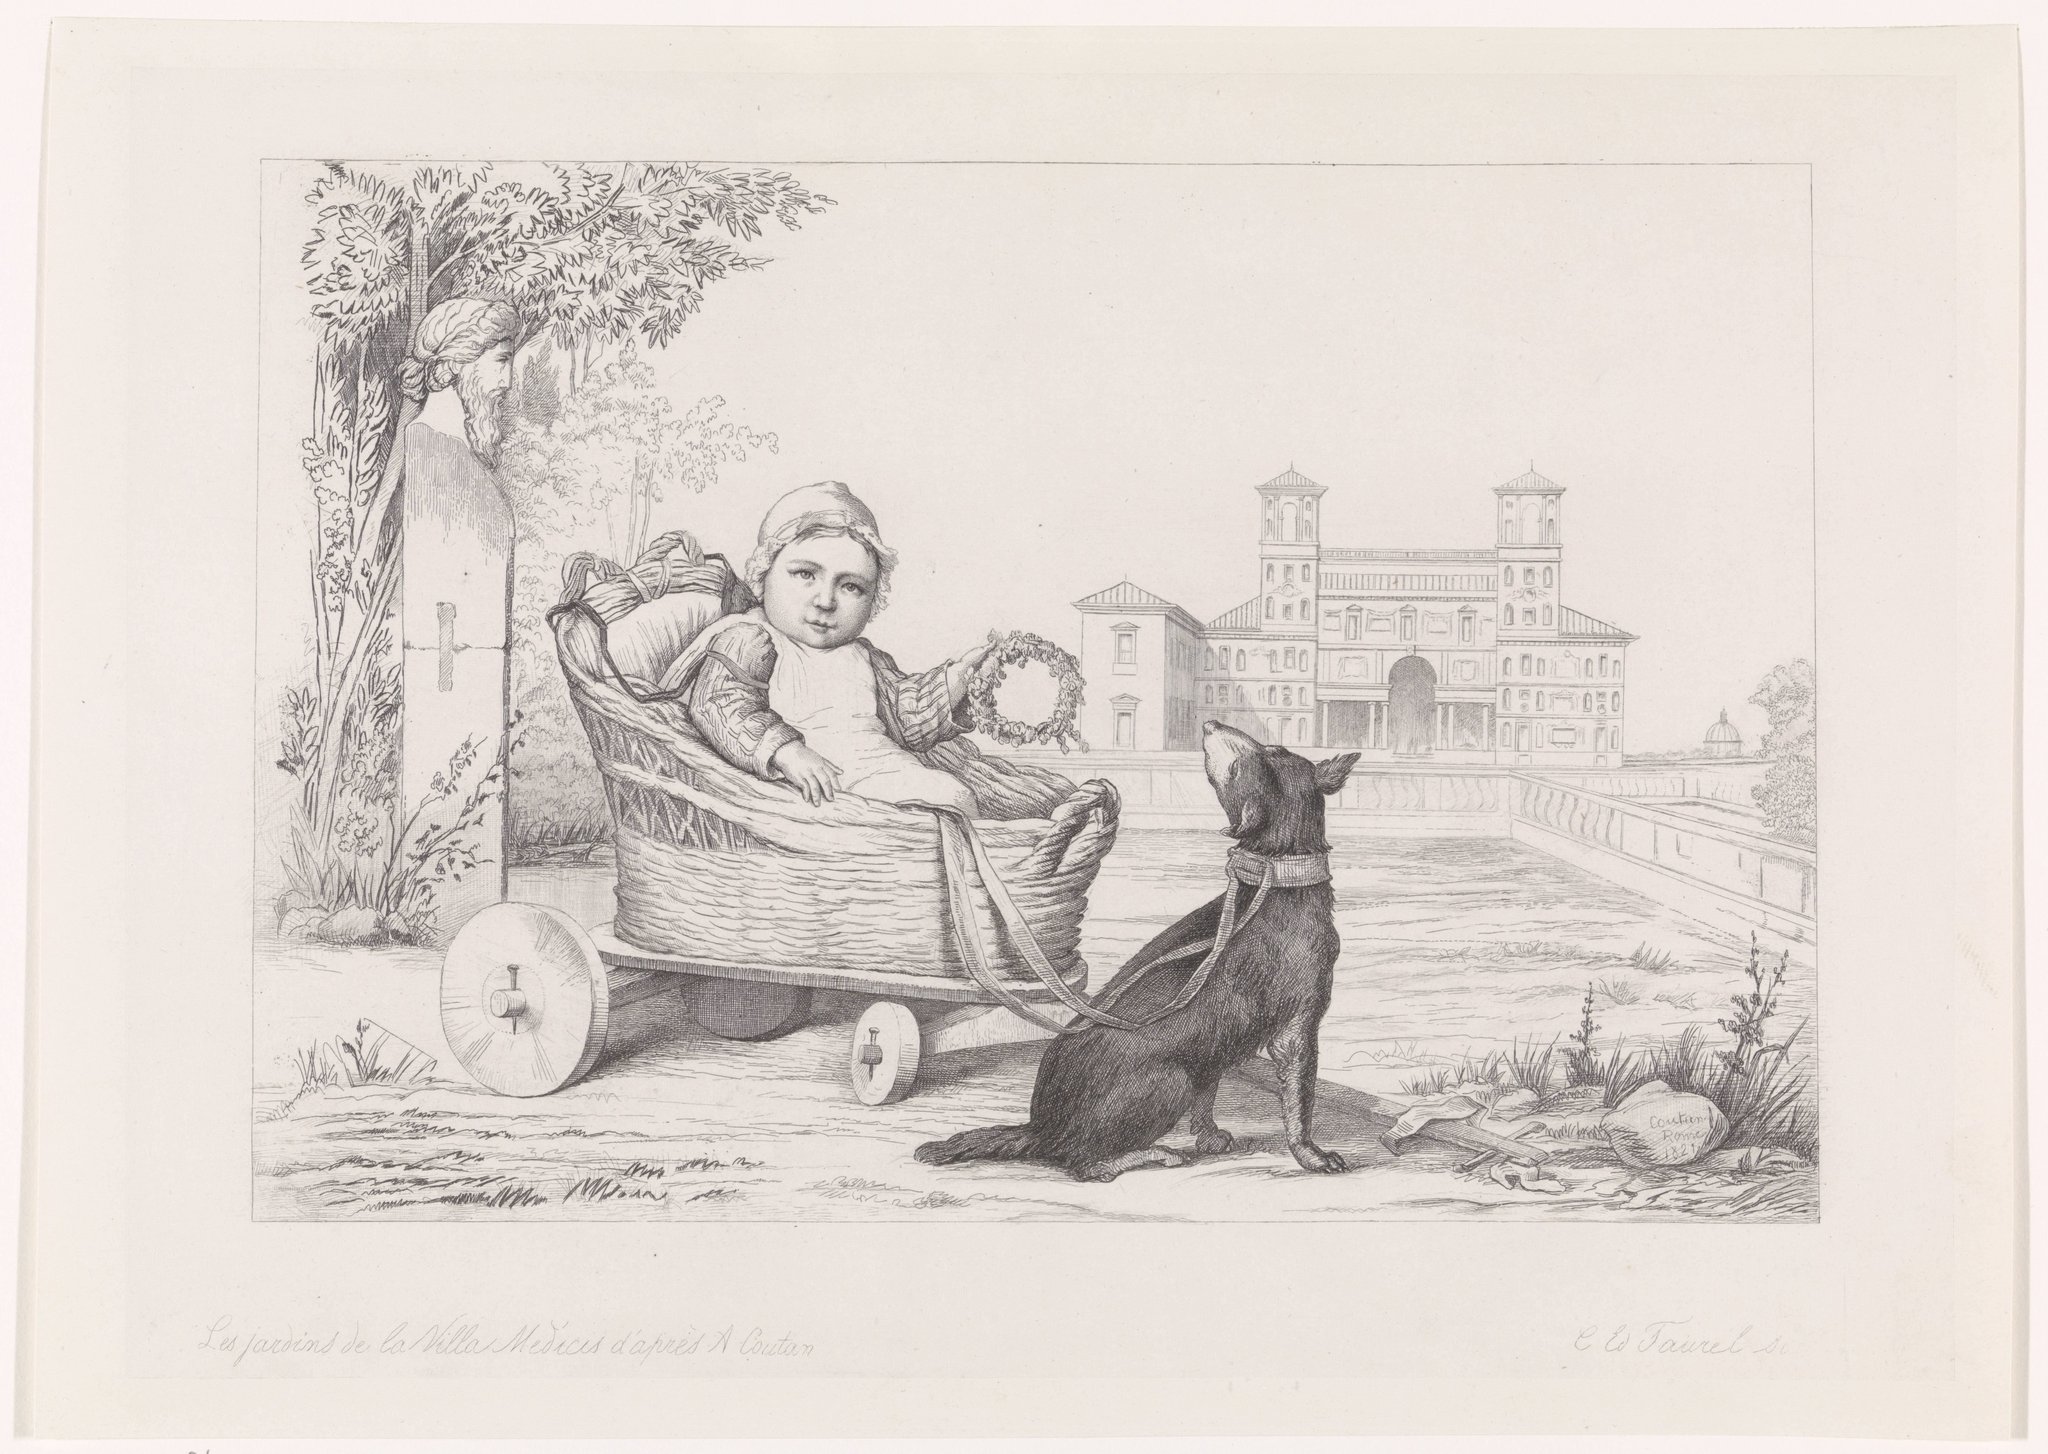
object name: print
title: Kinderwagen in de tuin van de villa de Medicis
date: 1885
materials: paper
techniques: etching, roulette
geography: amsterdam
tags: baby-carriage, pram, perambulator, dog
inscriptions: collector's mark: Lugt 2228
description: Prent ook gebruikt als illustratie in: L'album T. douze eaux-fortes d'après des dessins originaux et inédits de Jean Alaux, Léon Cogniet, Coutan, Henriquel Dupont, Ingres, Léopold Robert et Etna Michalon avec texte explicatif et biographique enrichi de lettres inédites. Amsterdam en Den Haag: 1885.